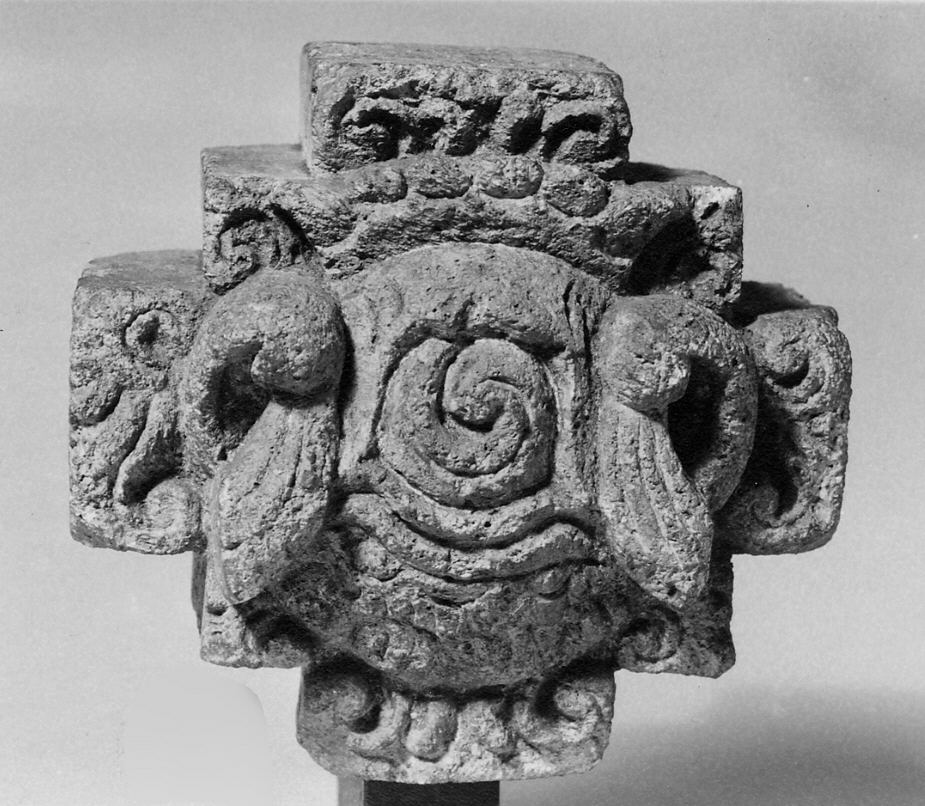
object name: pillar fragment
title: Fragment from the Top of a Pillar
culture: indonesian, javanese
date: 1801-2000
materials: stone